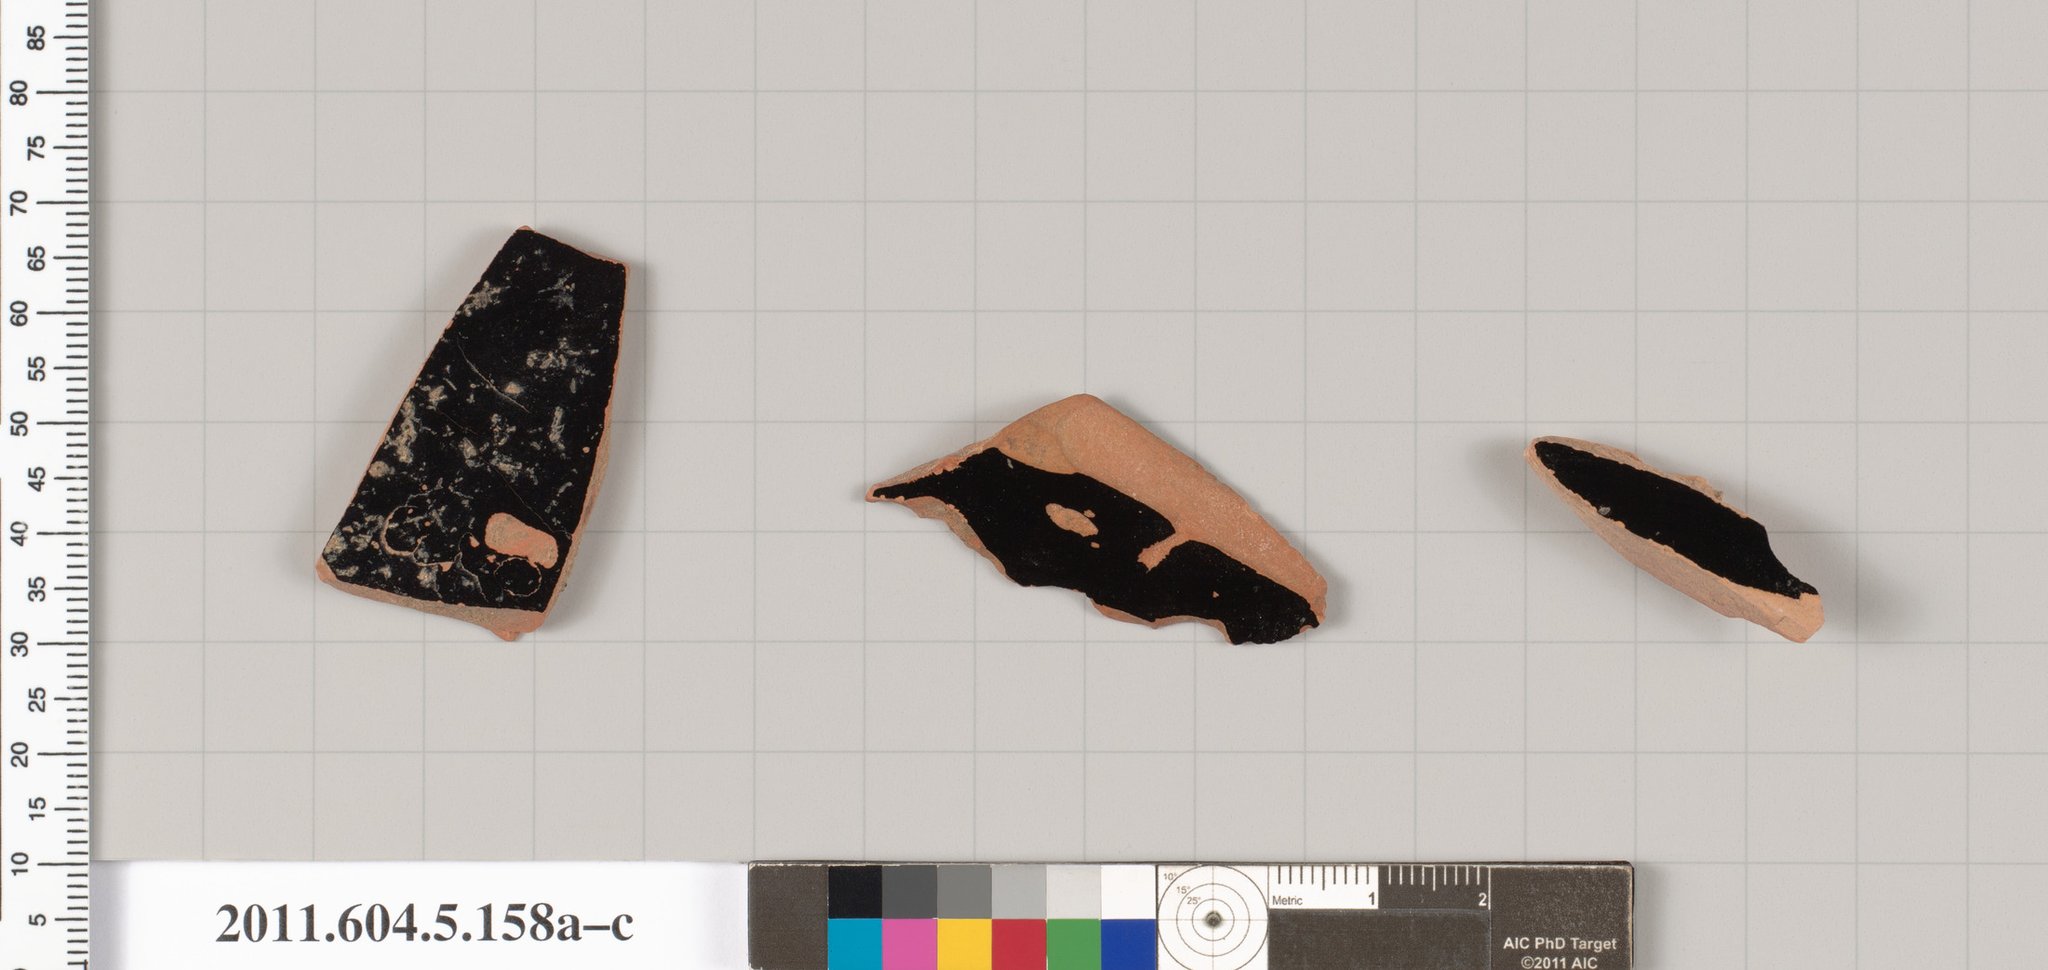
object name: kylix fragment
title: Terracotta fragments of kylikes (drinking cups)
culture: greek, attic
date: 600-401 BCE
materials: terracotta